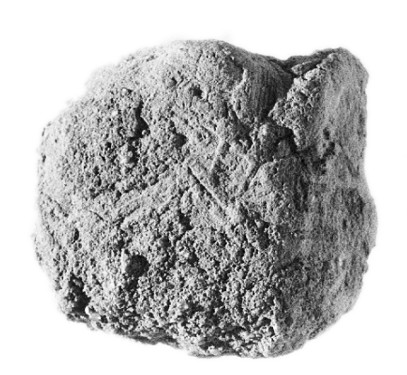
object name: sealing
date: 1981-1640 BCE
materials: mud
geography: egypt